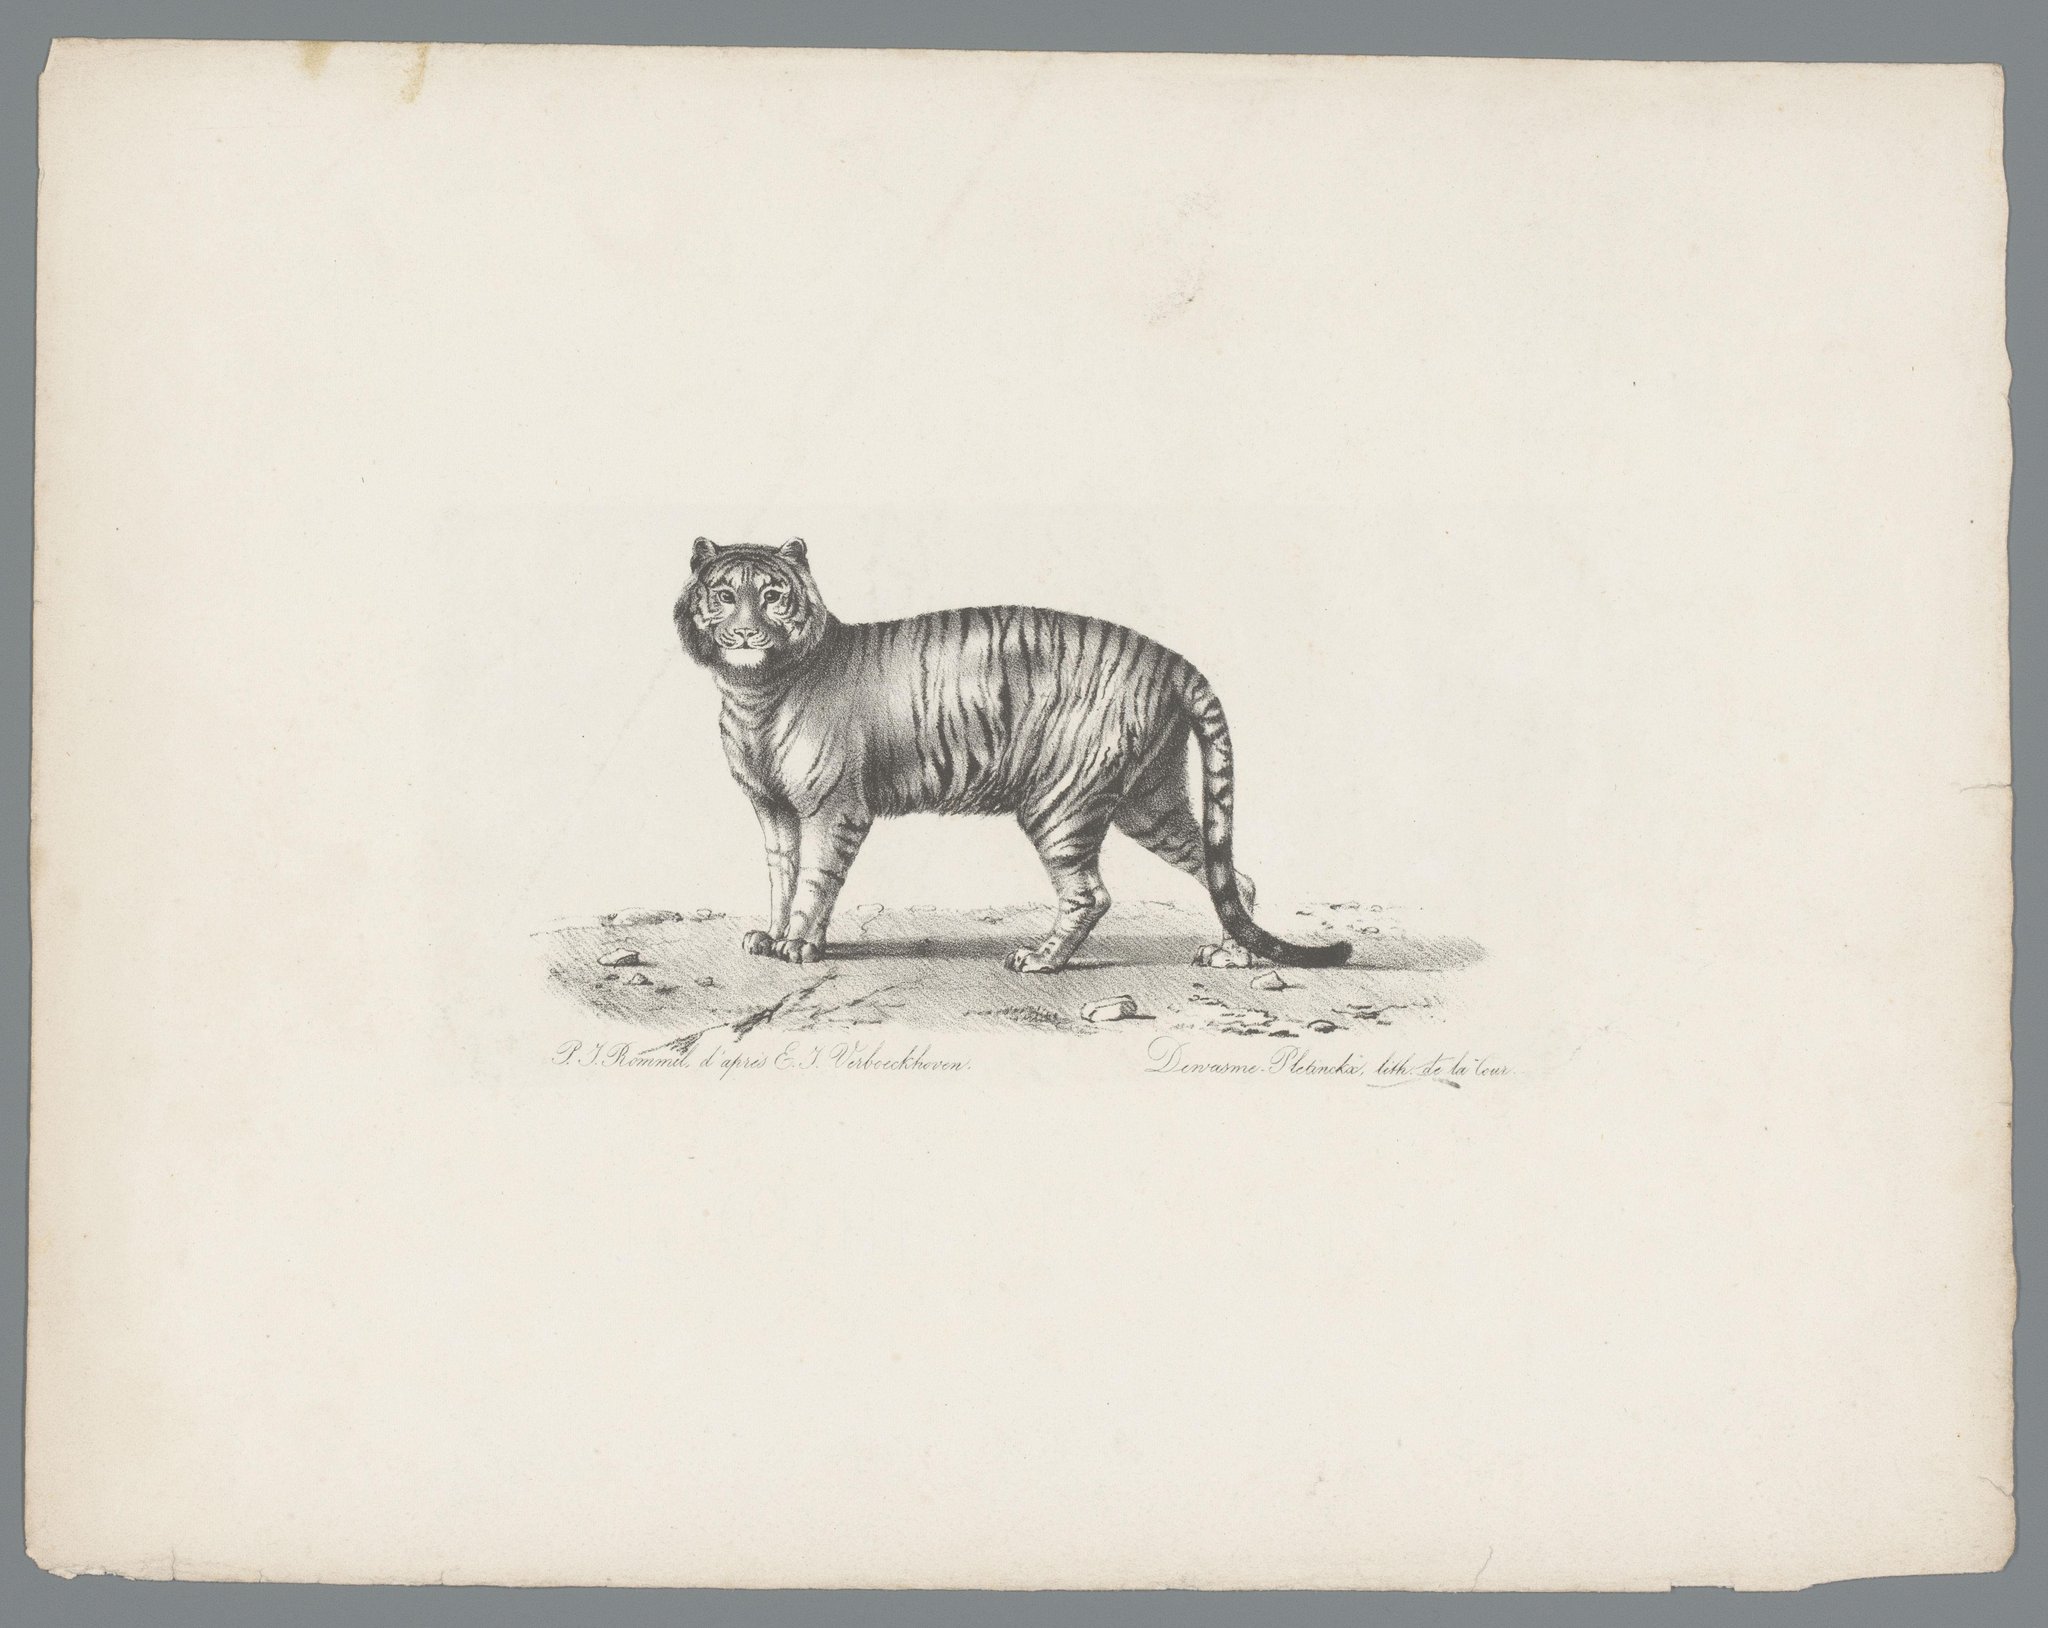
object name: print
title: Tijger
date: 1824-1827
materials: paper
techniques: lithograph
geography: brussels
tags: beasts of prey, predatory animals: tiger